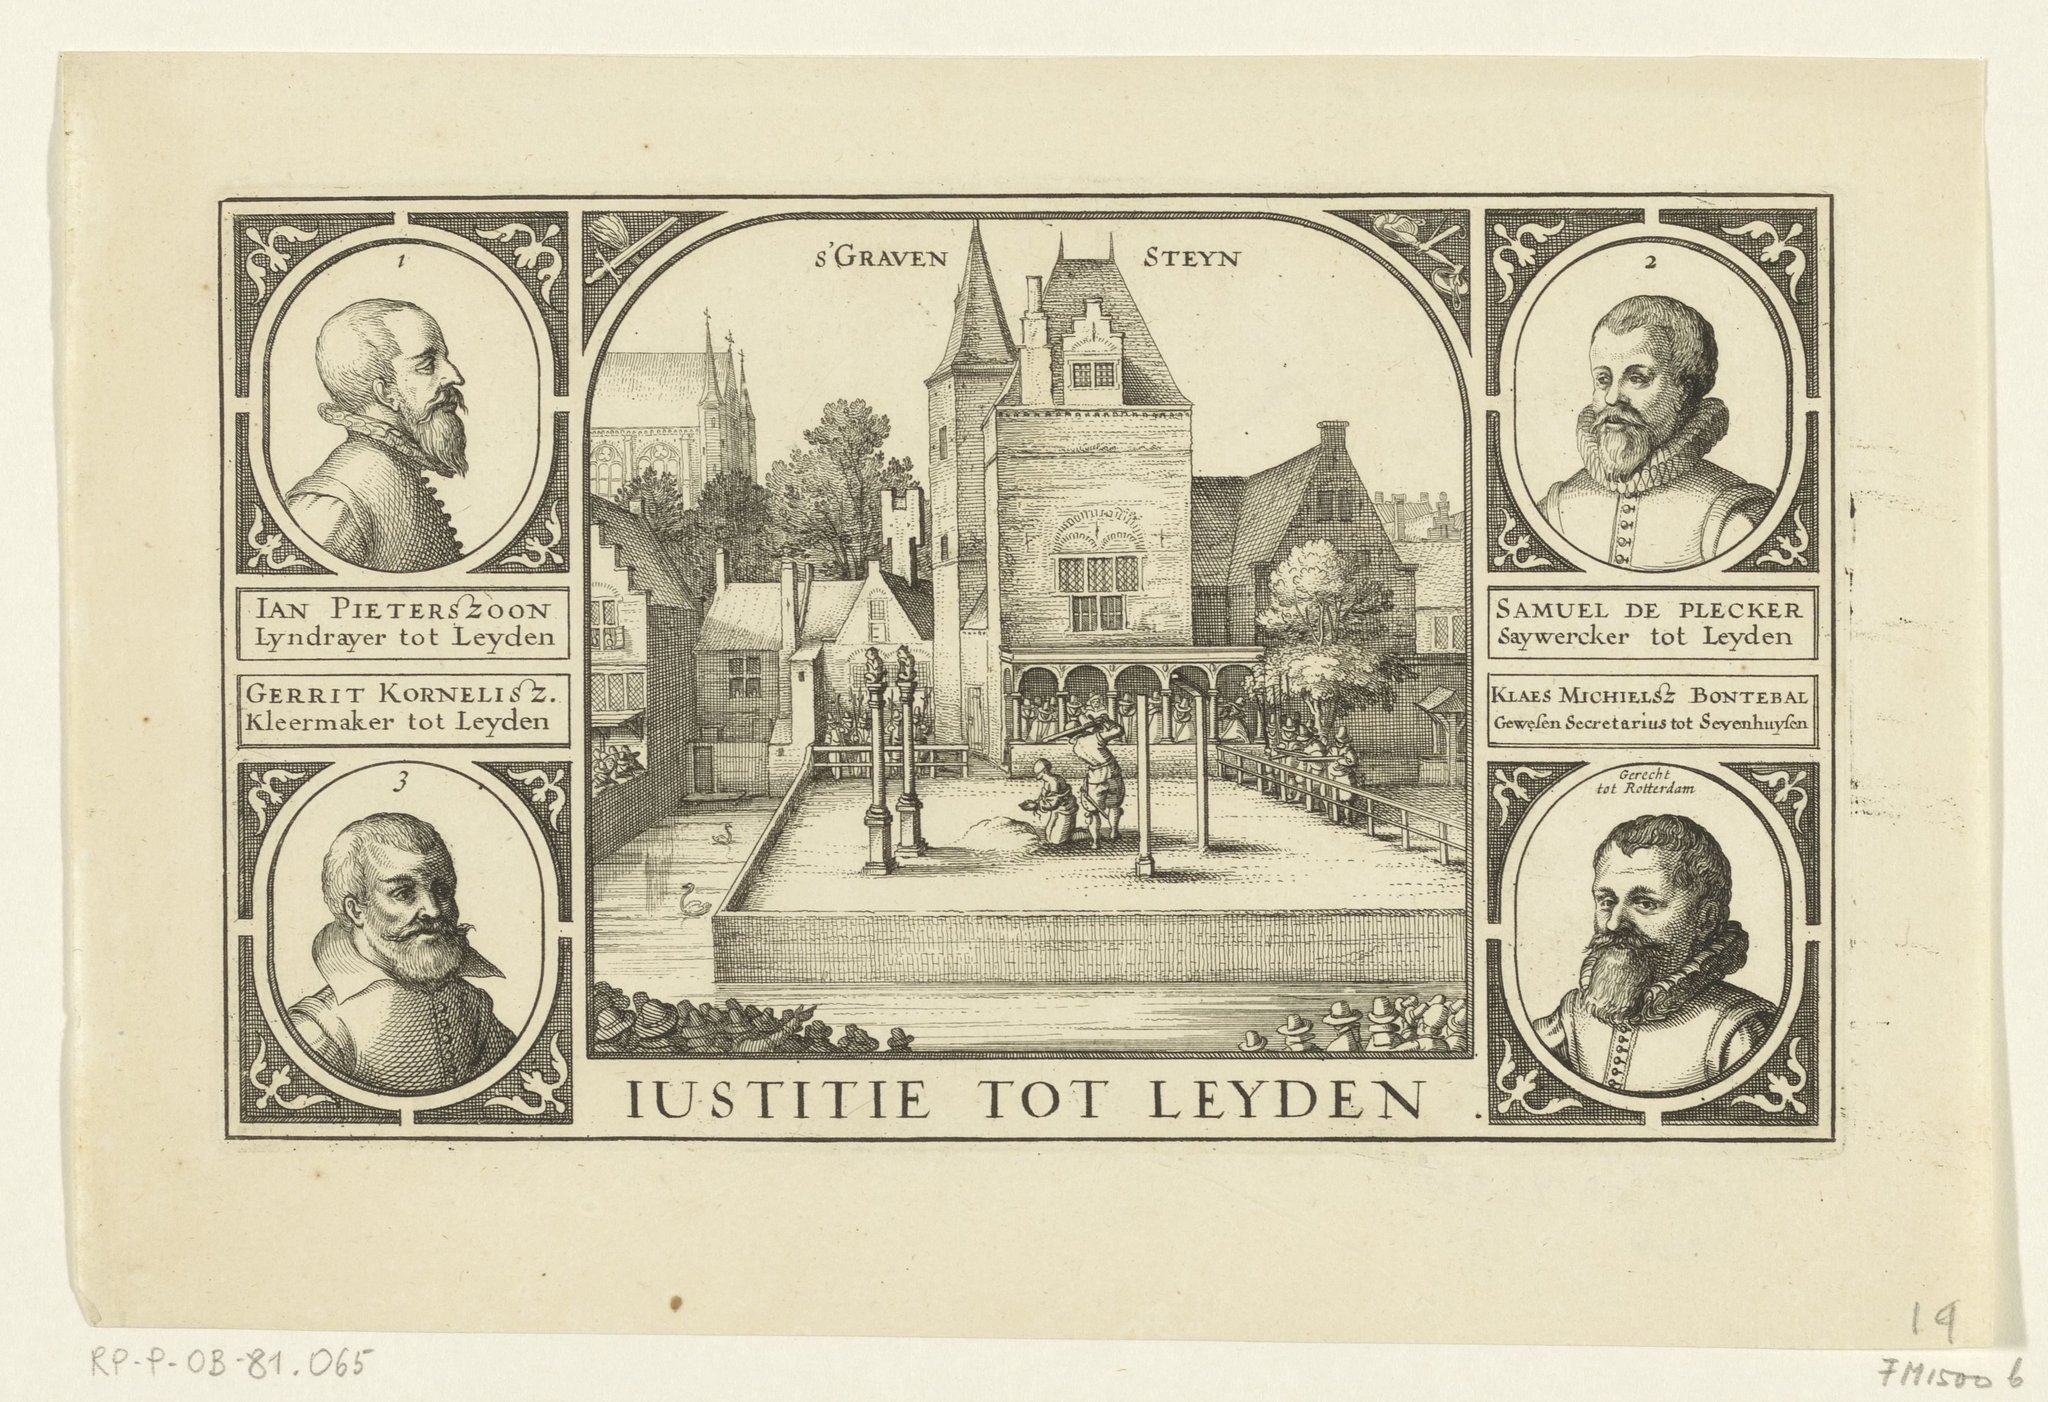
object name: print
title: Afbeelding der Justitie / soo tot Leyden als Rotterdam over eenighe arminiaensche verraders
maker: claes jansz. visscher (ii)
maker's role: draughtsman, print maker, publisher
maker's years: 1586-1652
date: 1623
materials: paper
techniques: etching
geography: amsterdam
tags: maurice (prince of orange), rotterdam, leiden, arrest (of criminal), violent death by beheading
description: De onthoofding van vier arminianen Jan Pieterszoon, Gerrit Kornelisz. en Samuel de Plecker bij het Gravensteen te Leiden op 21 juni 1623 en Klaas Michielsz. Bontebal onthoofd op 3 juli 1623 te Rotterdam, allen veroordeeld als medeplichtigen aan de samenzwering tegen Maurits. Een onthoofding op het terrein bij het Gravensteen te Leiden, hieromheen portretten van de vier veroordeelden.